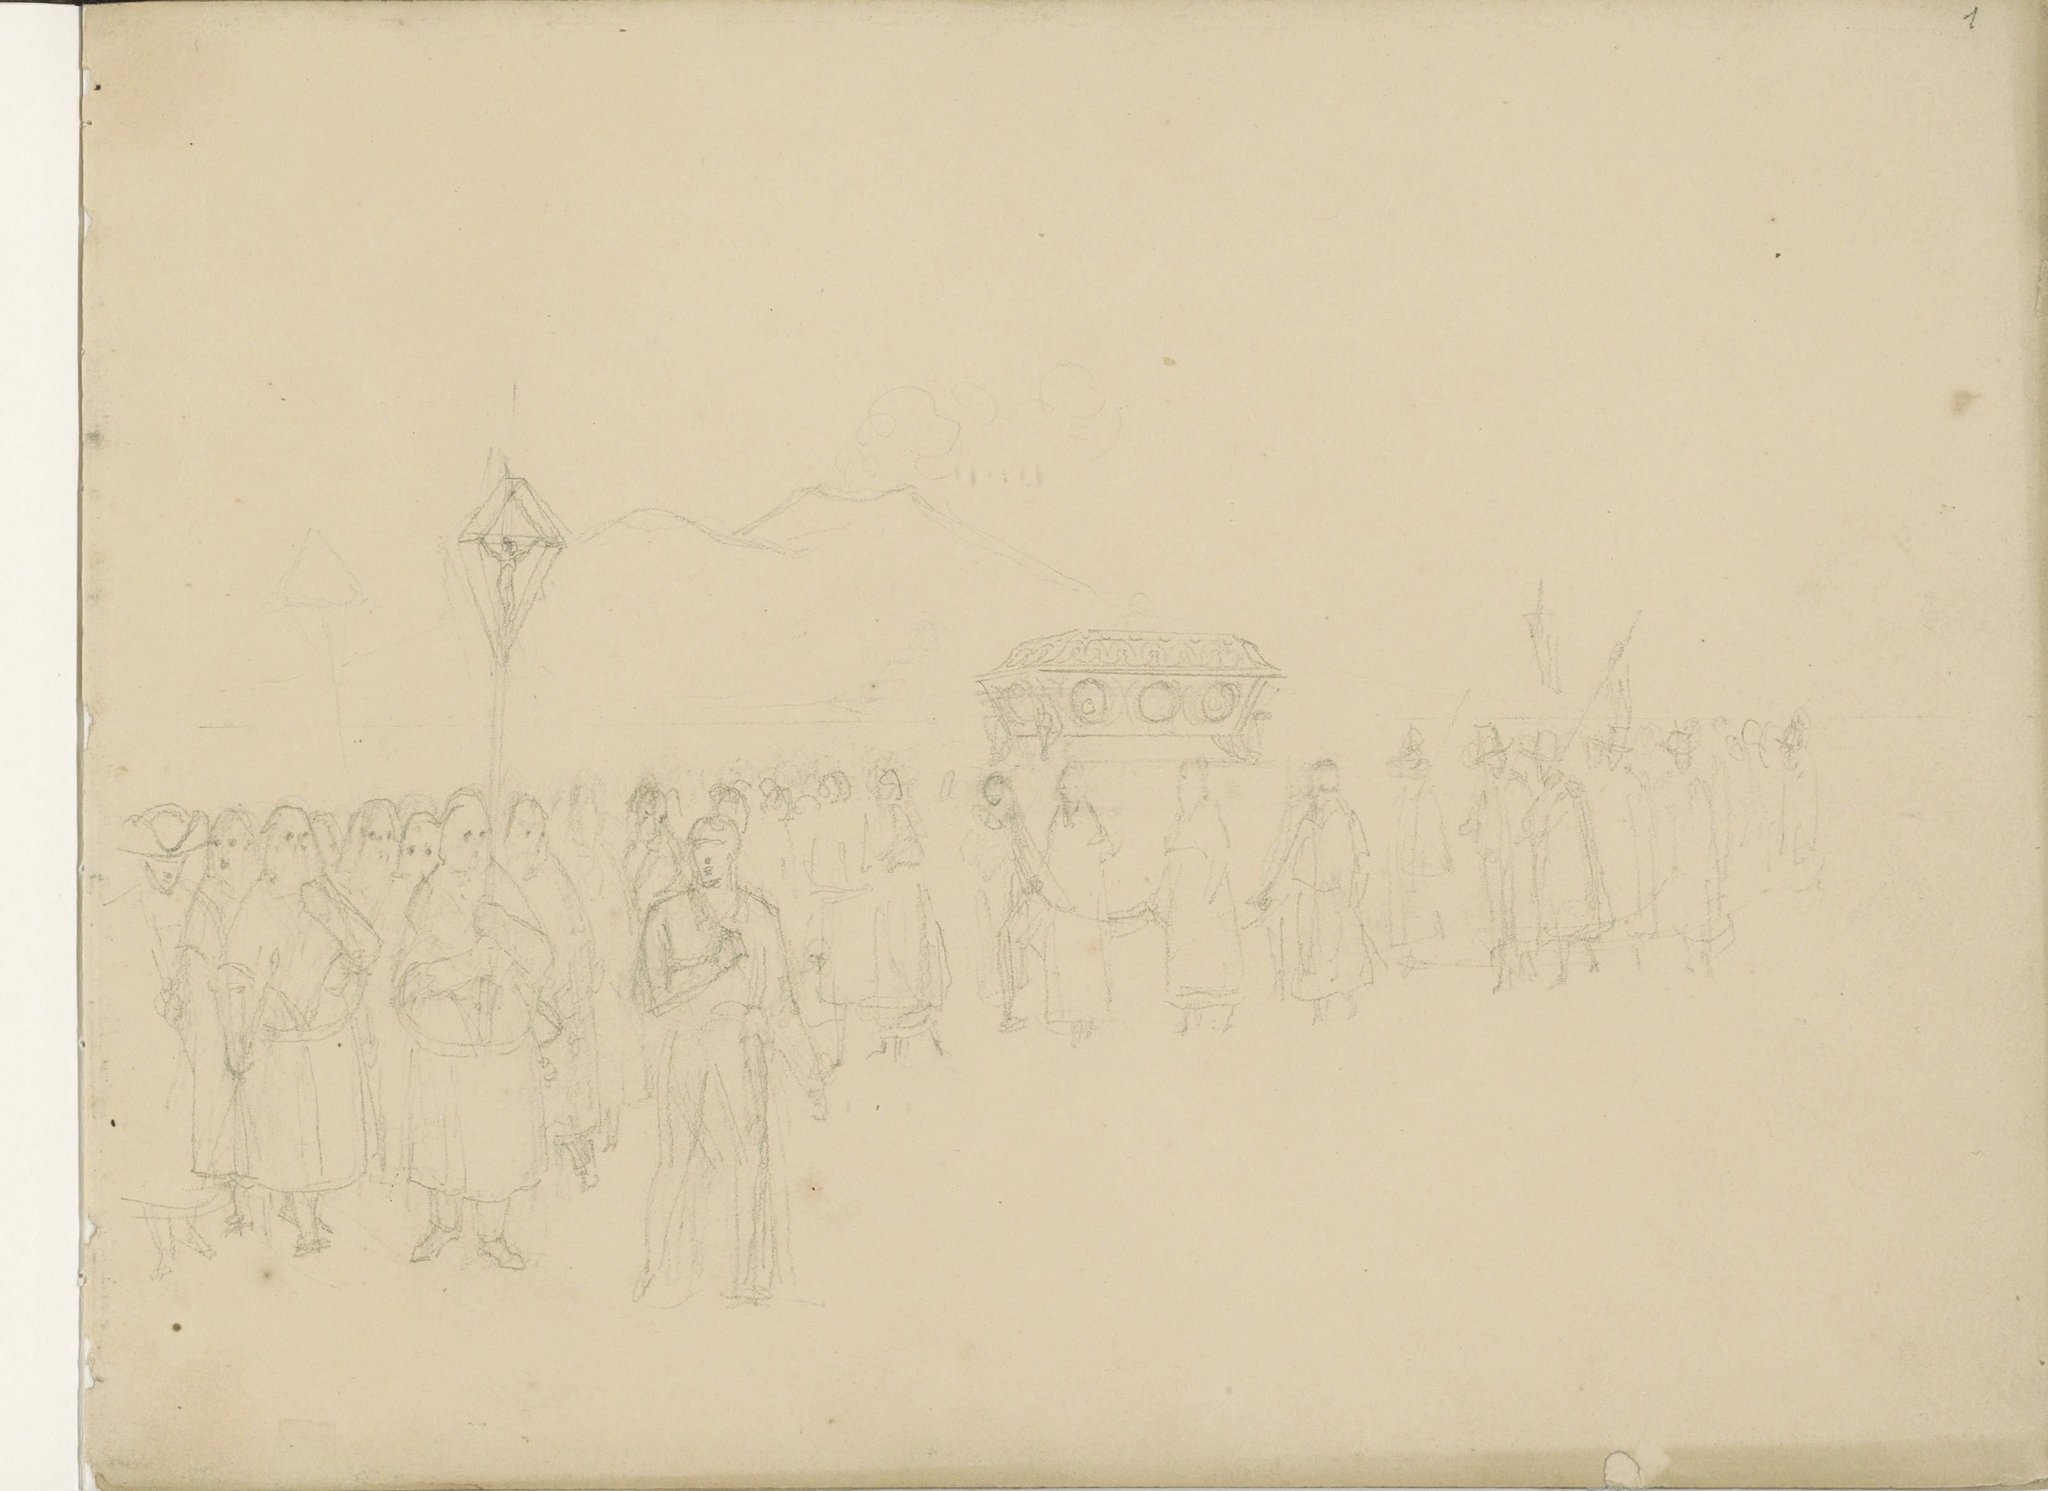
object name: sketchbook leaf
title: Processie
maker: jacobus everhardus josephus van den berg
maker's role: draughtsman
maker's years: 1802-1861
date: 1830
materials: paper, pencil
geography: italy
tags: procession ~ christian religion, italy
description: Blad 1 recto uit een schetsboek met 26 bladen.